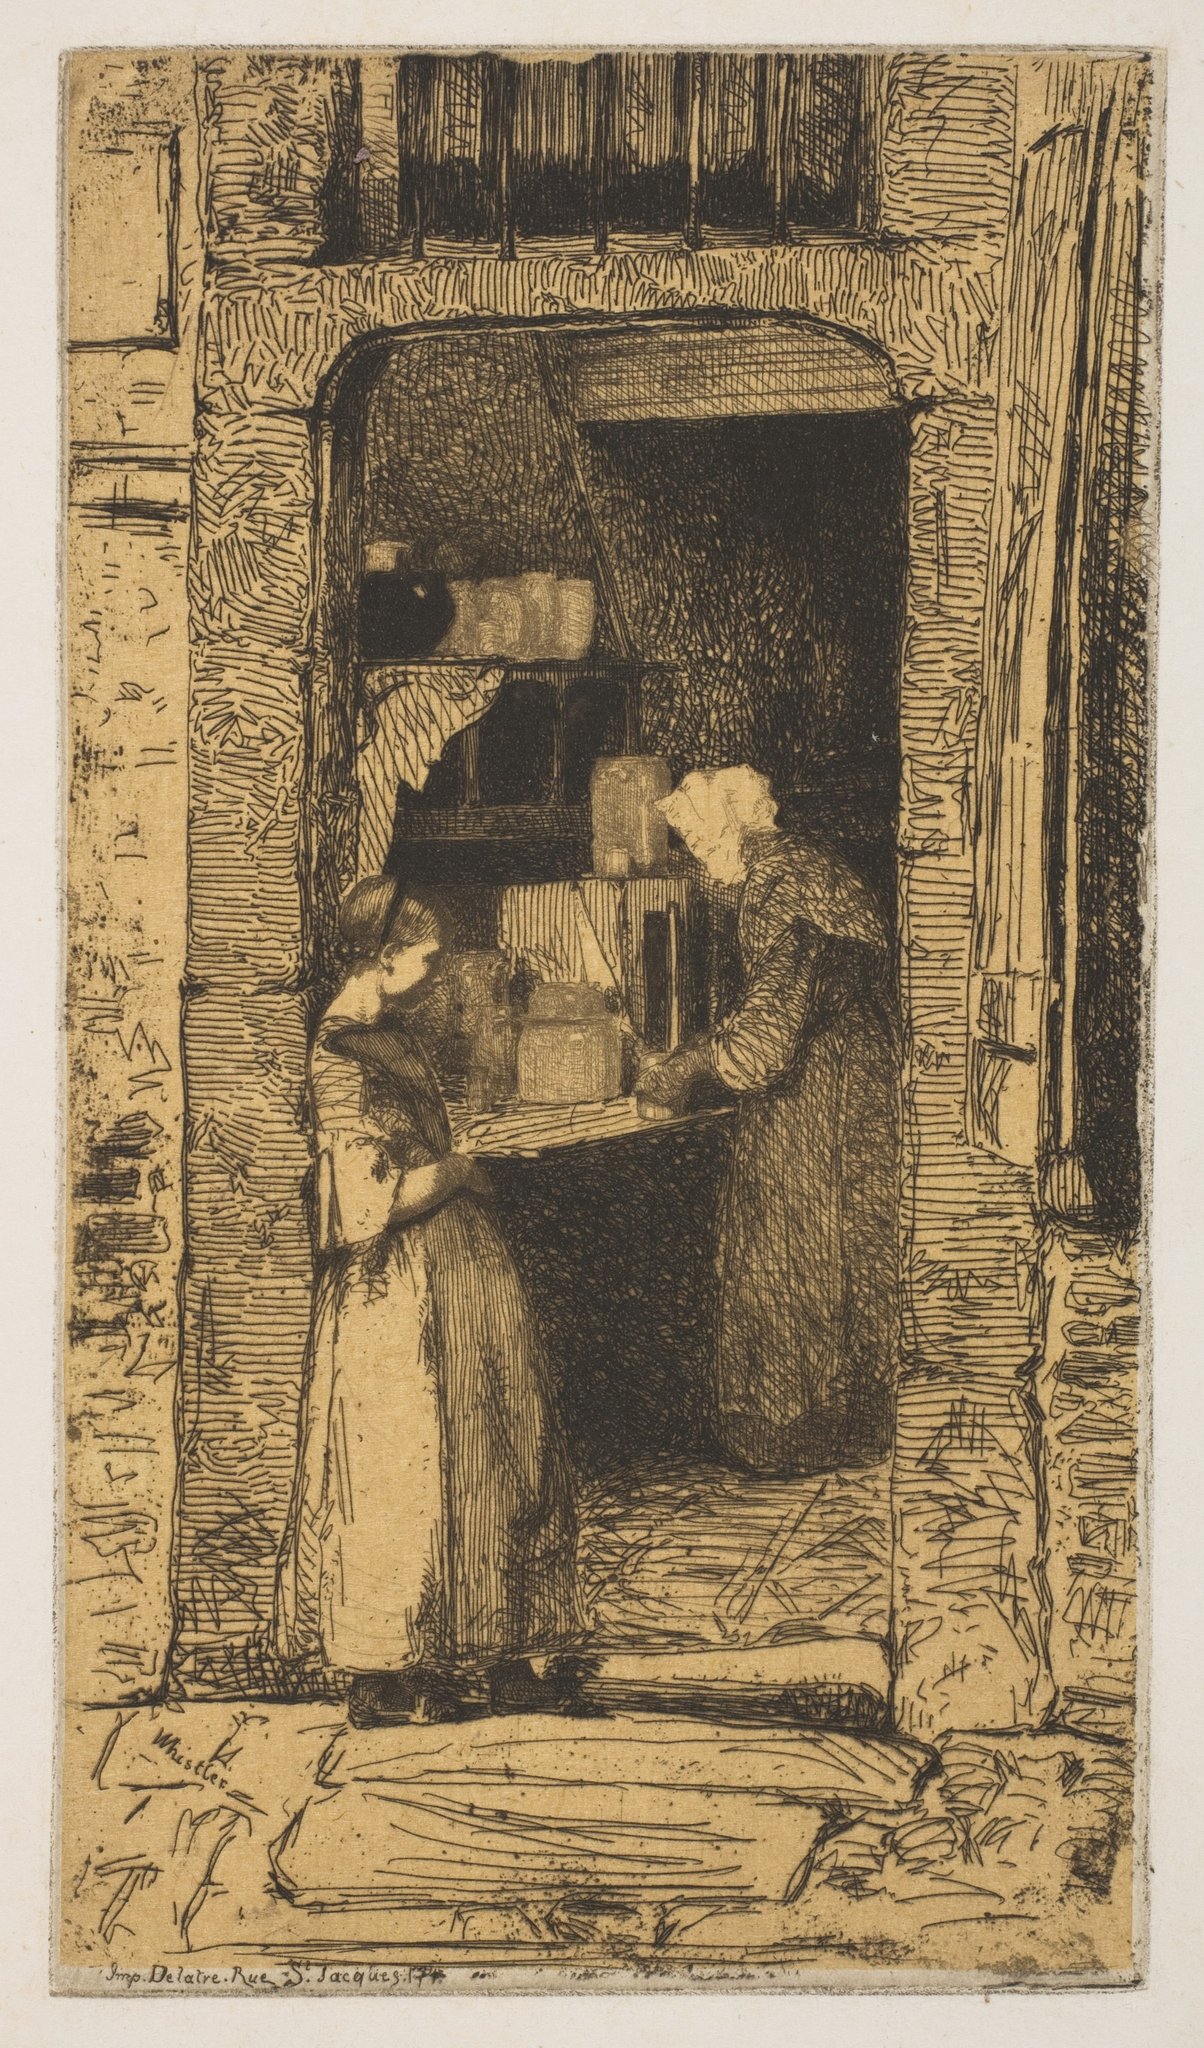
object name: print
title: La Marchande de moutarde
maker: james mcneill whistler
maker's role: artist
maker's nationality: american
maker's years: 1834-1903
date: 1858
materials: chine, paper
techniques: printmaking, etching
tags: doorways,girls,women,merchants